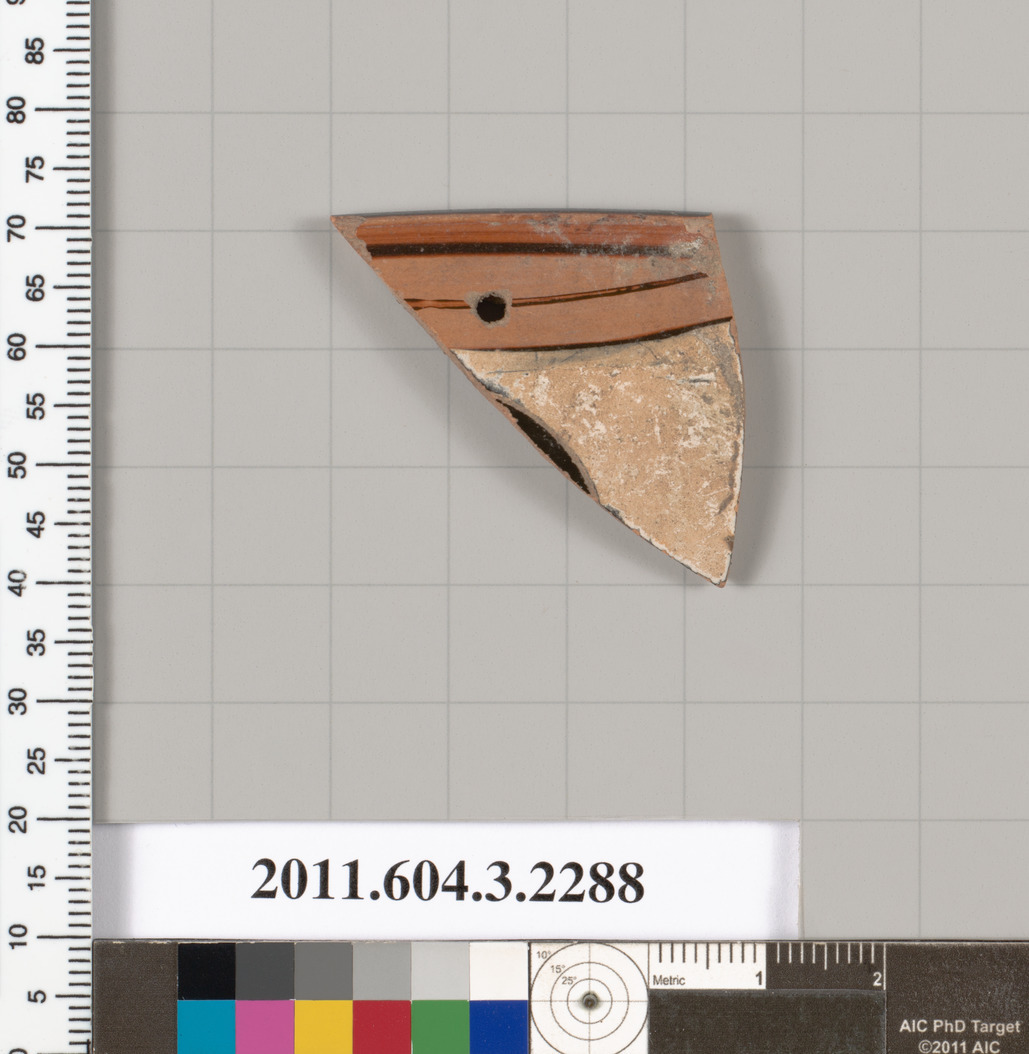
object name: kylix fragment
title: Terracotta rim fragment of a kylix: eye-cup (drinking cup)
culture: greek, attic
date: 530-510 BCE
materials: terracotta